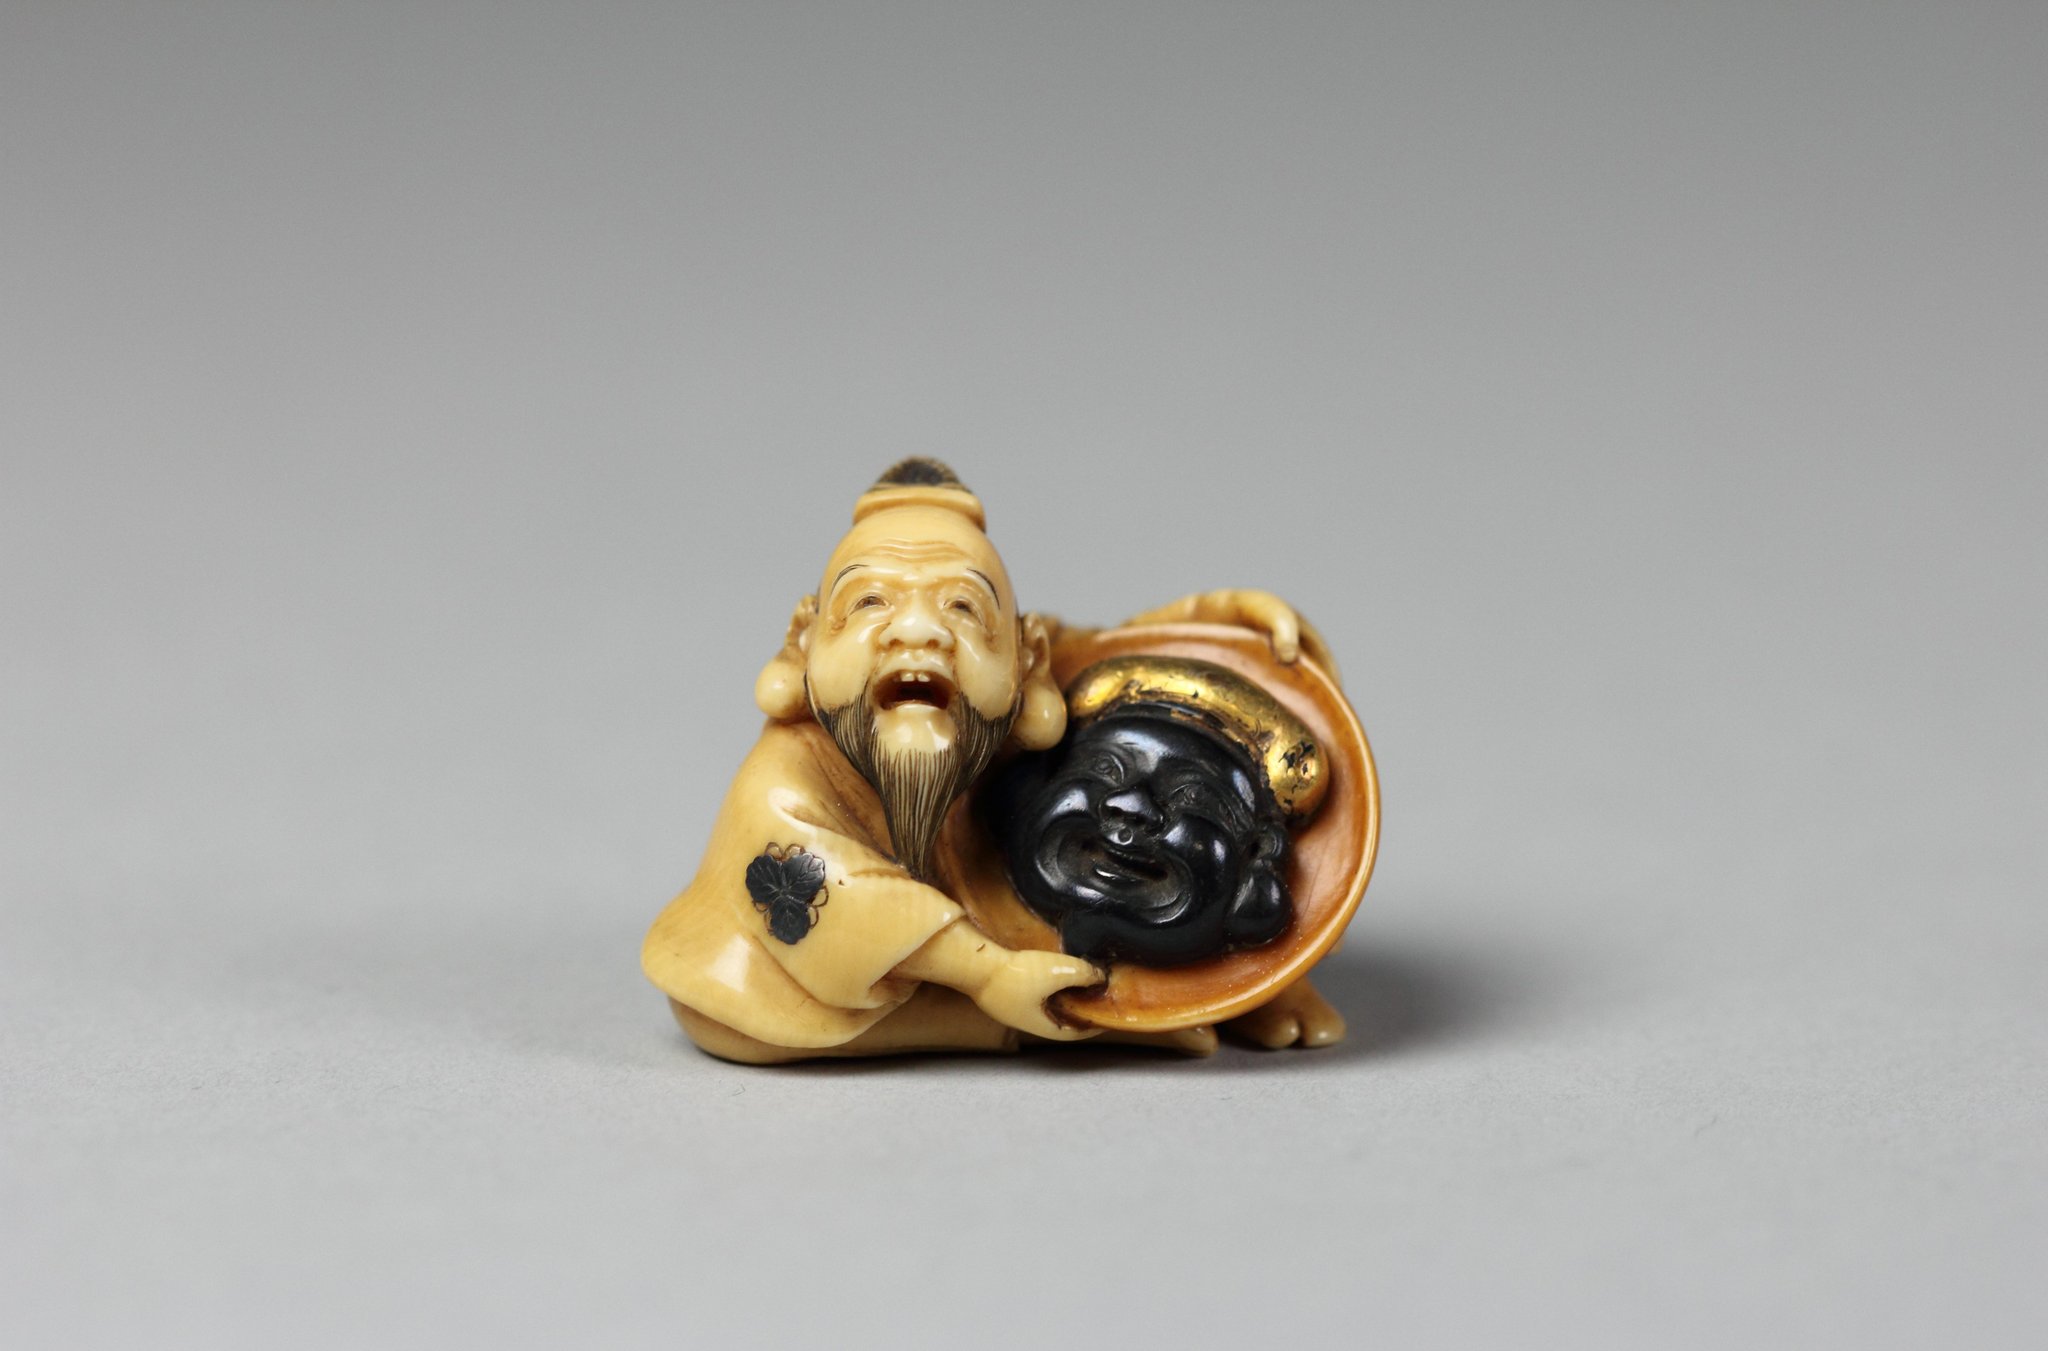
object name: netsuke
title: Netsuke of Daikoku with Hotei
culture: japanese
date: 1801-1900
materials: gold, ivory, silver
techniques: inlay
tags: masks,men